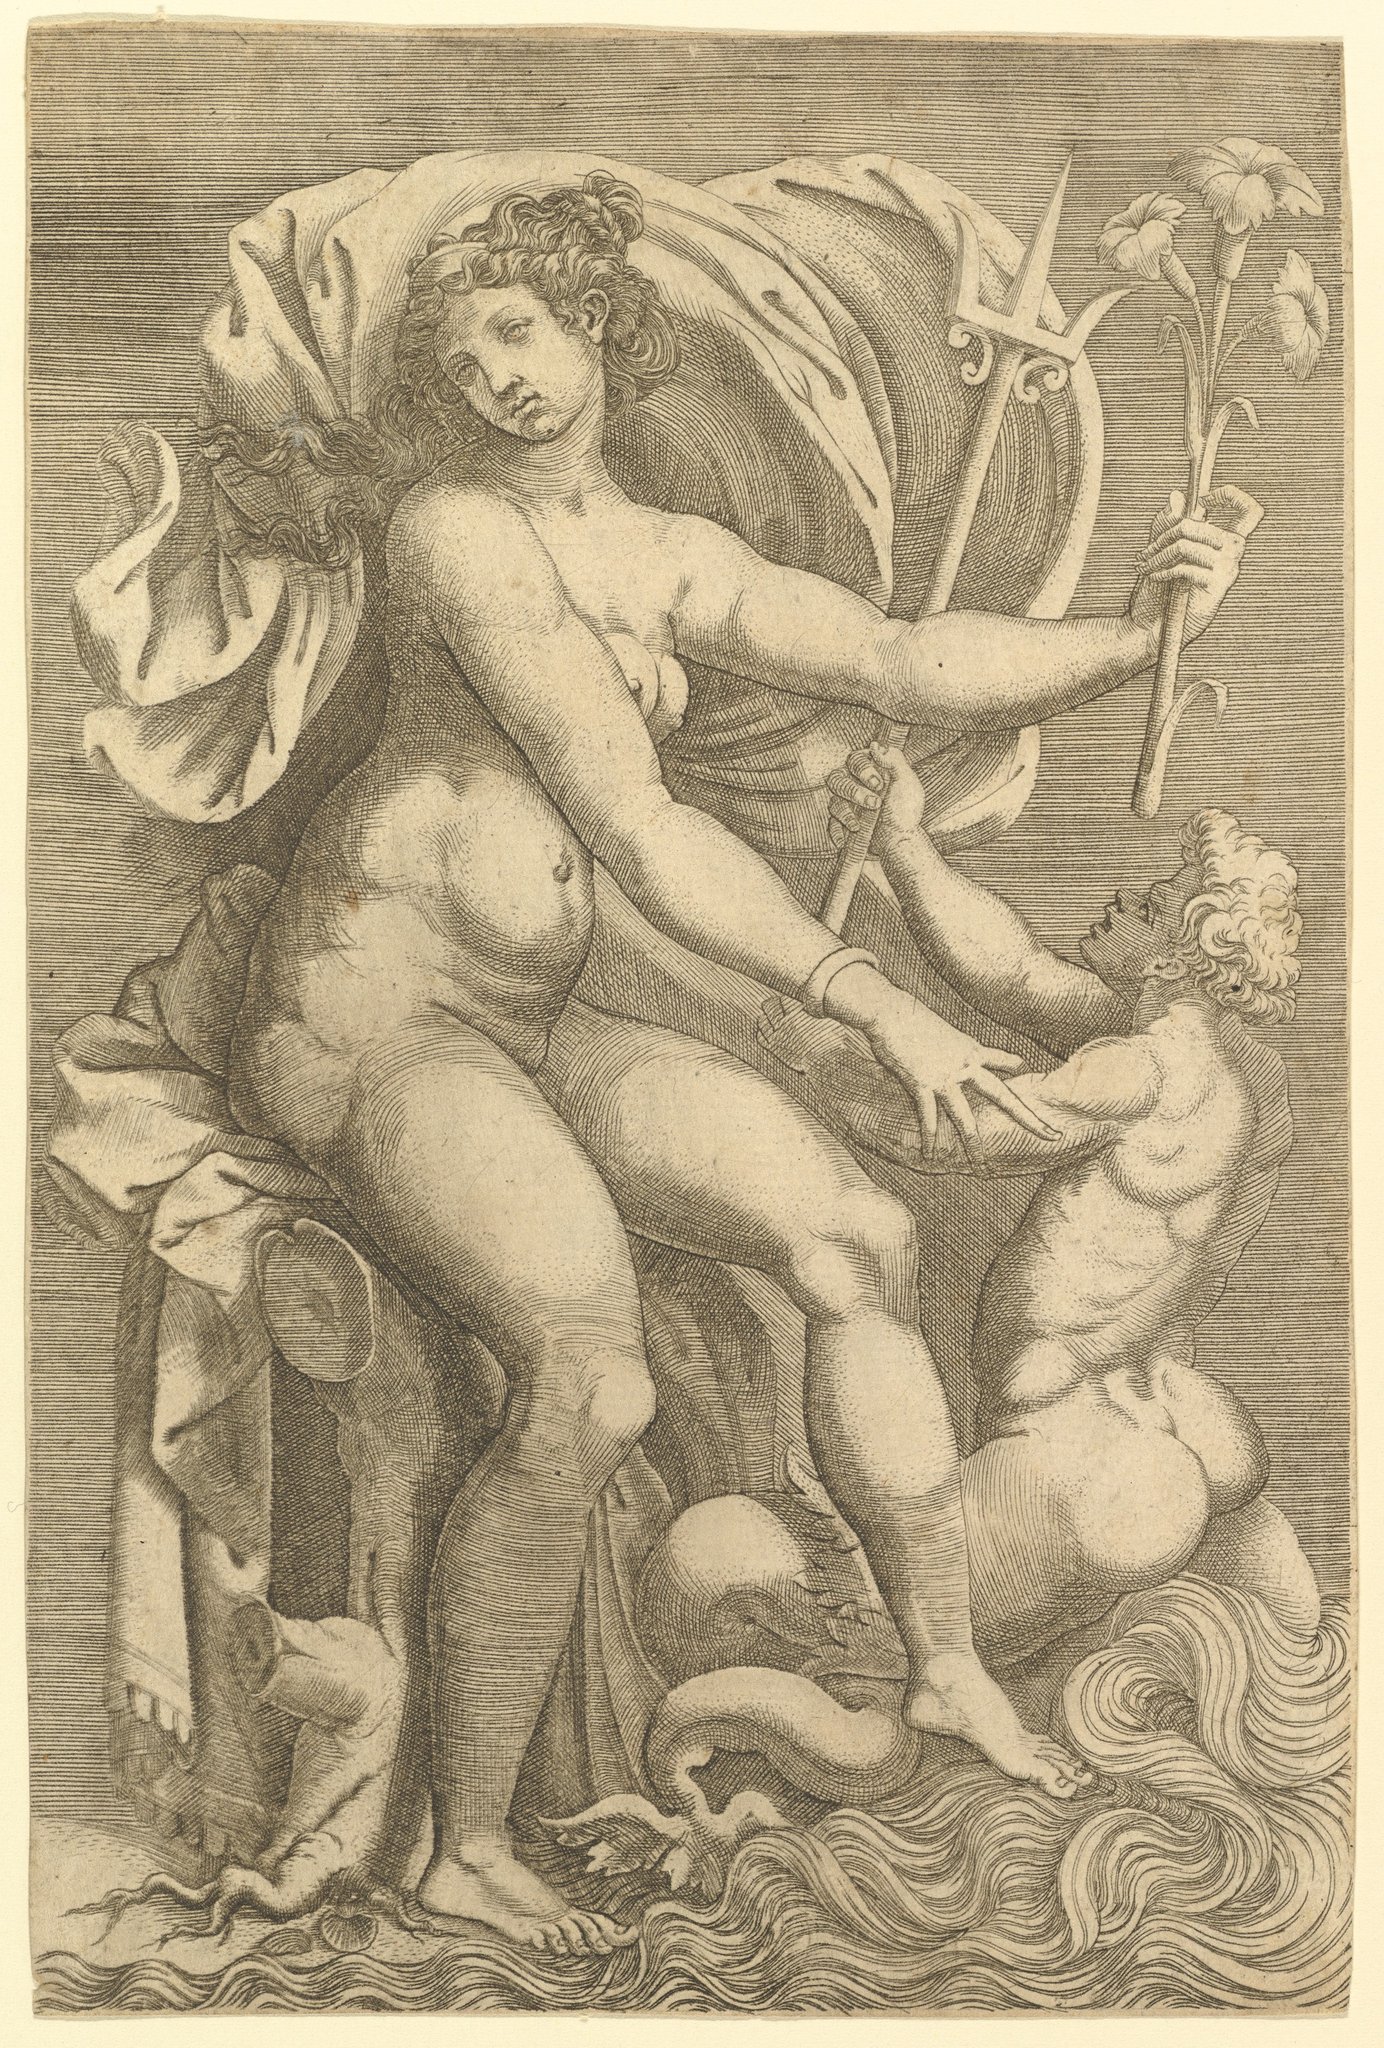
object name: print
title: Thetis Seated with a Triton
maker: anonymous, italian?, 16th century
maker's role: artist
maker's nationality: italian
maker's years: 1500-1600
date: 1520-1582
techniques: engraving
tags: triton,goddess